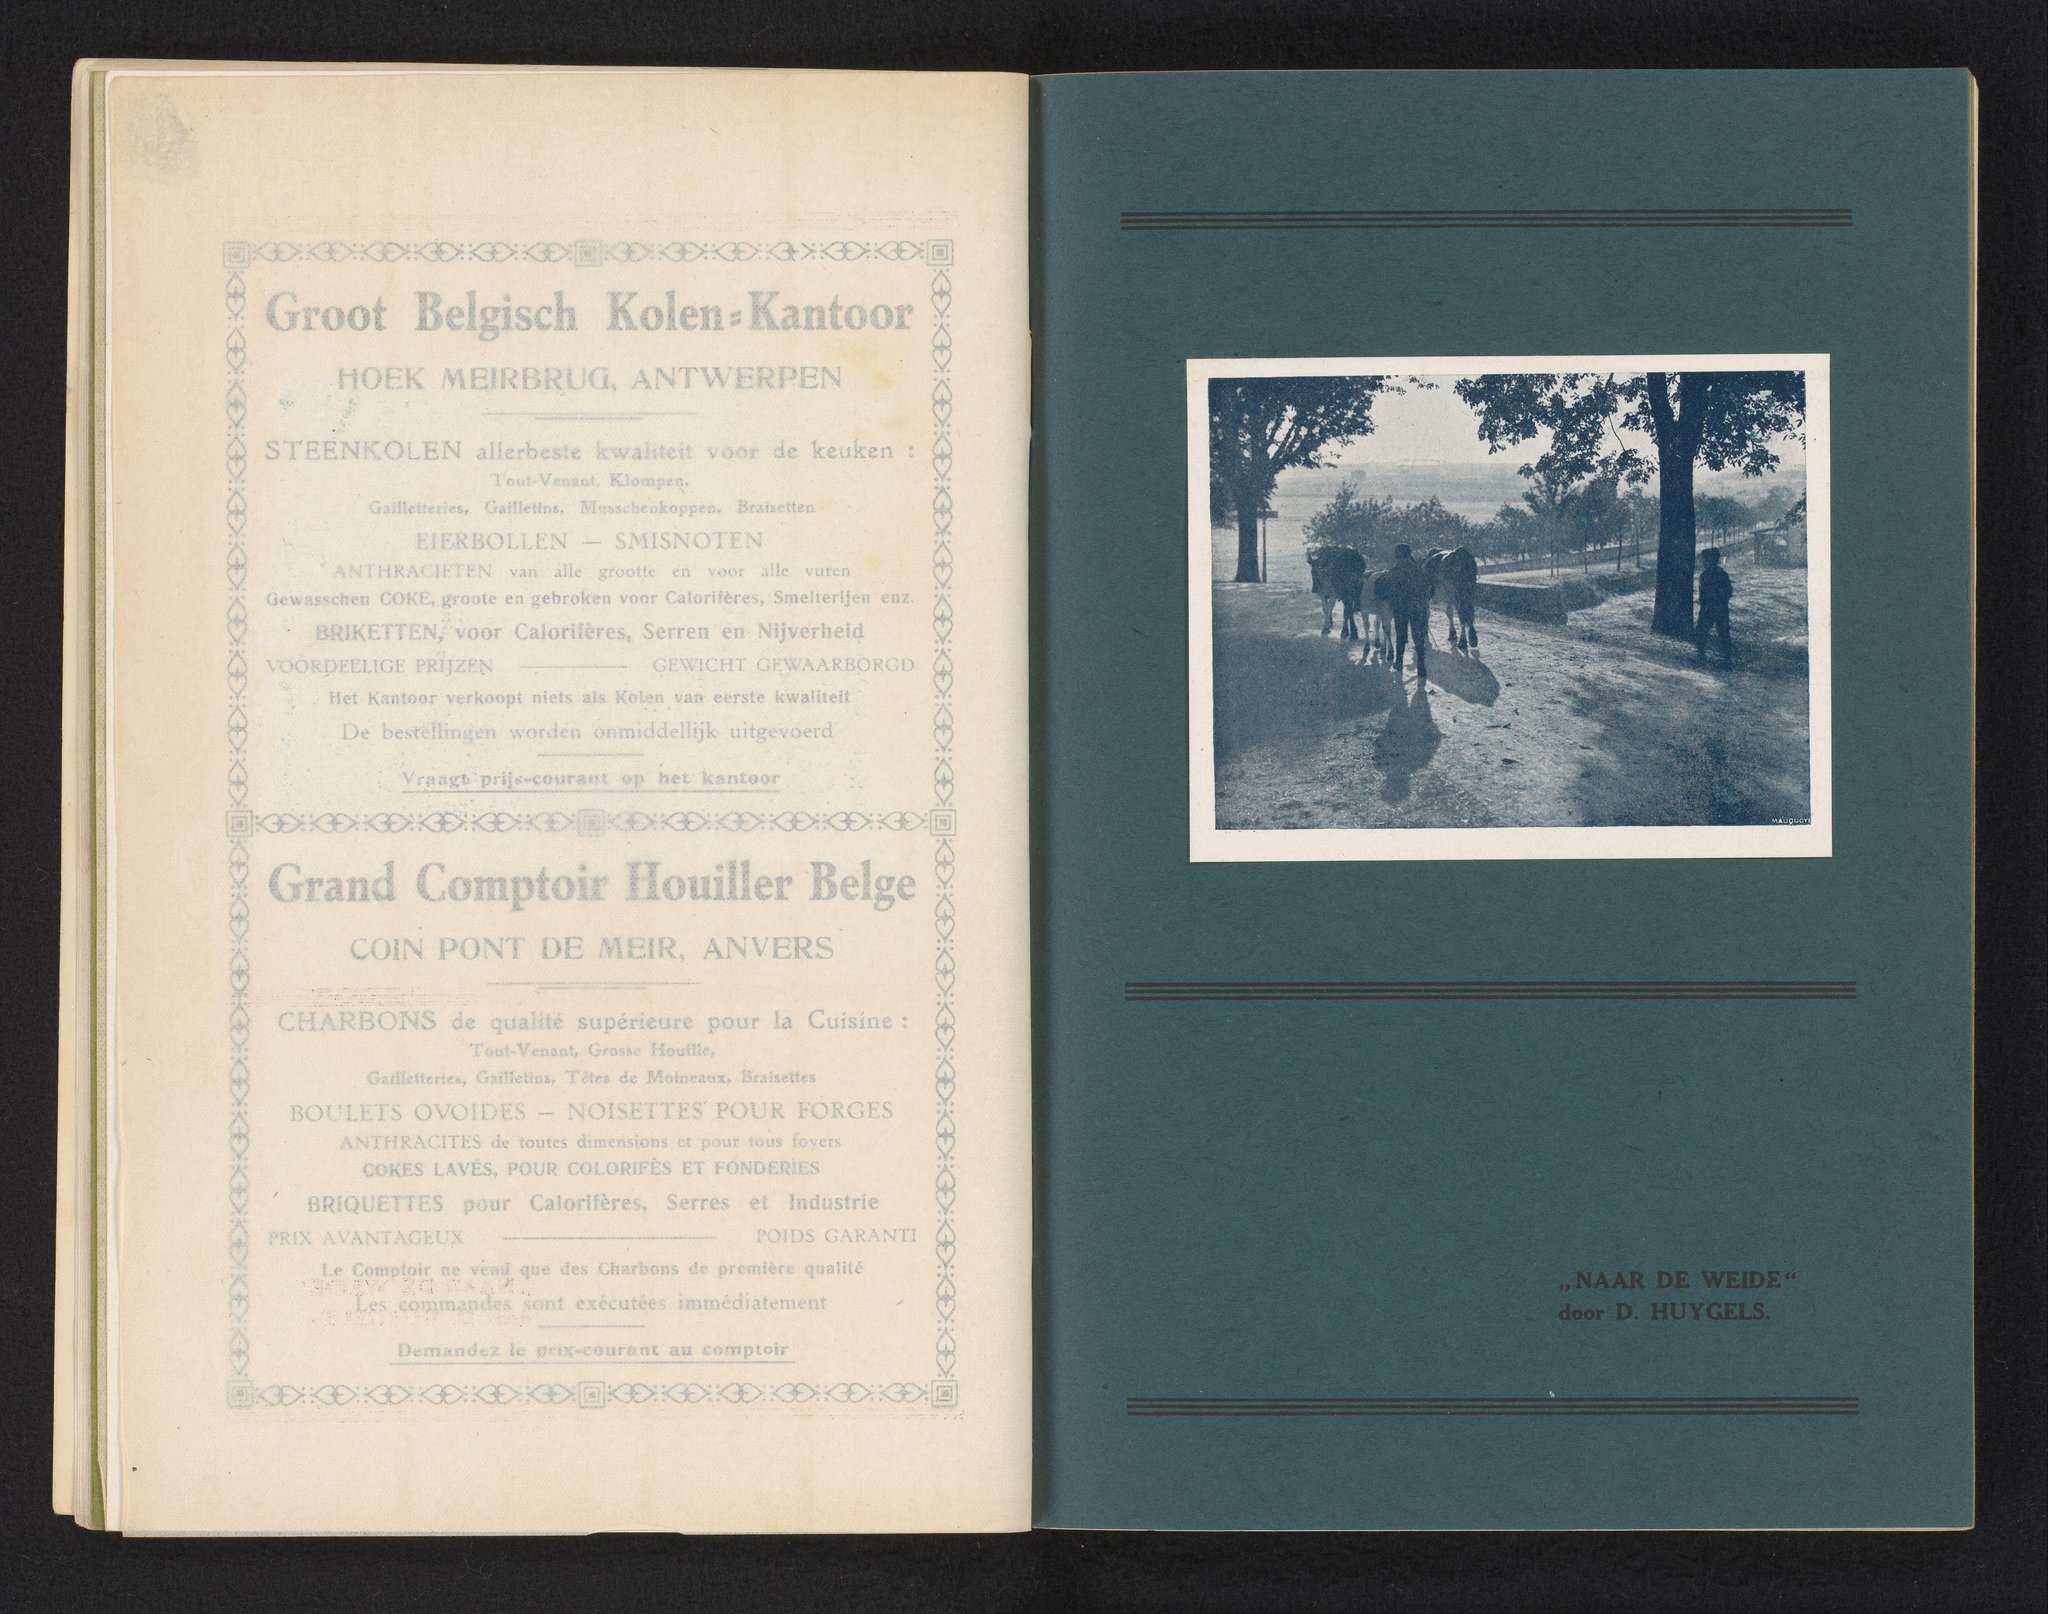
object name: photomechanical print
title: Naar de weide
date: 1911-1916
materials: paper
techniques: autotype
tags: cow, herding, herdsman, herdswoman, shepherd, shepherdess, cowherd, etc., road, path